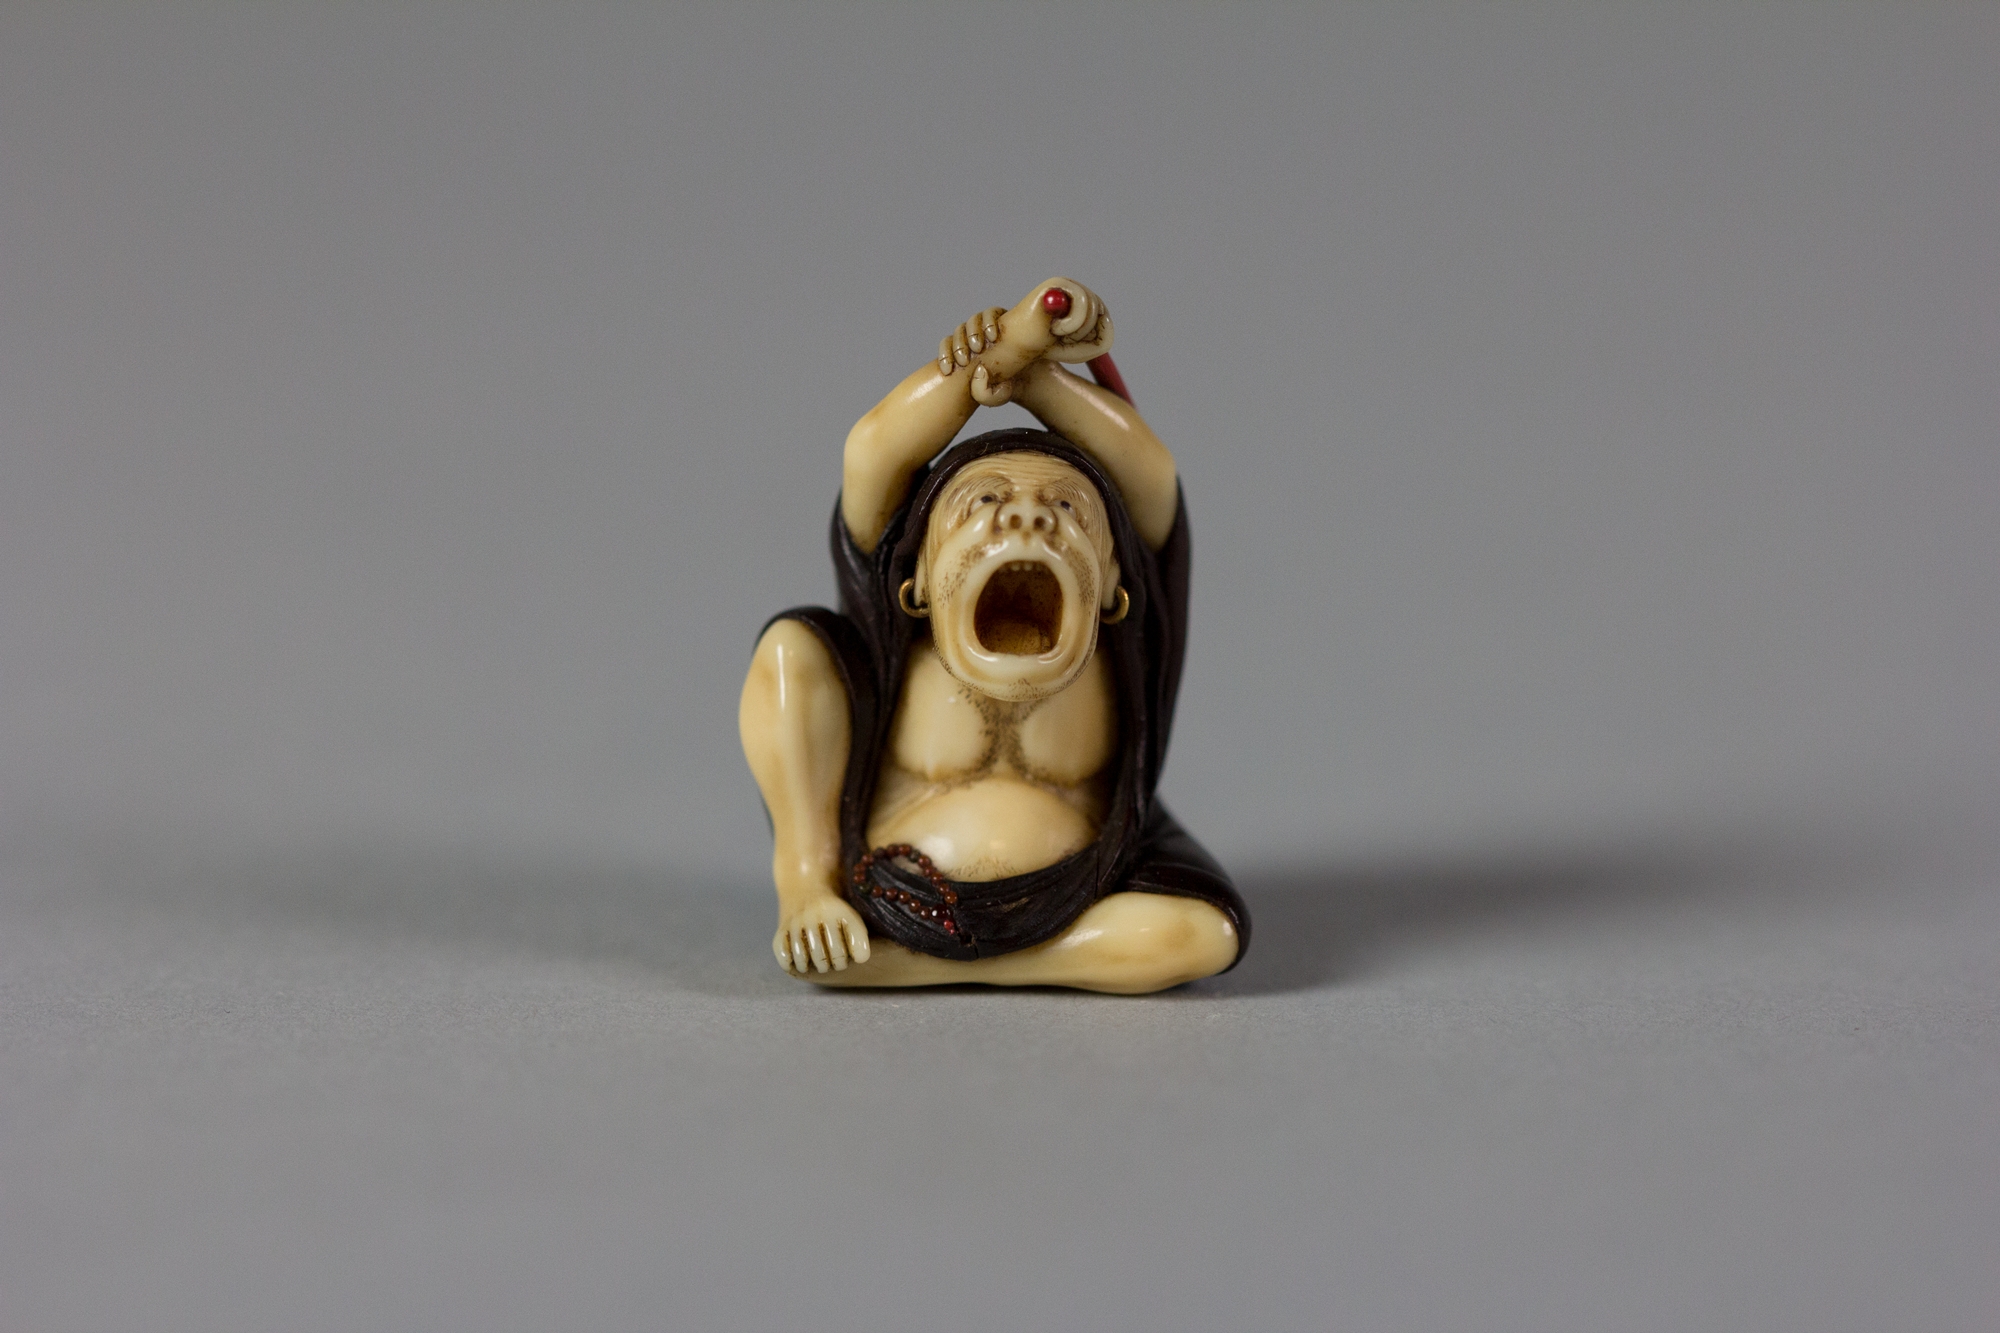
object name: netsuke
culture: japanese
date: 1801-1900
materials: ivory, wood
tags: men